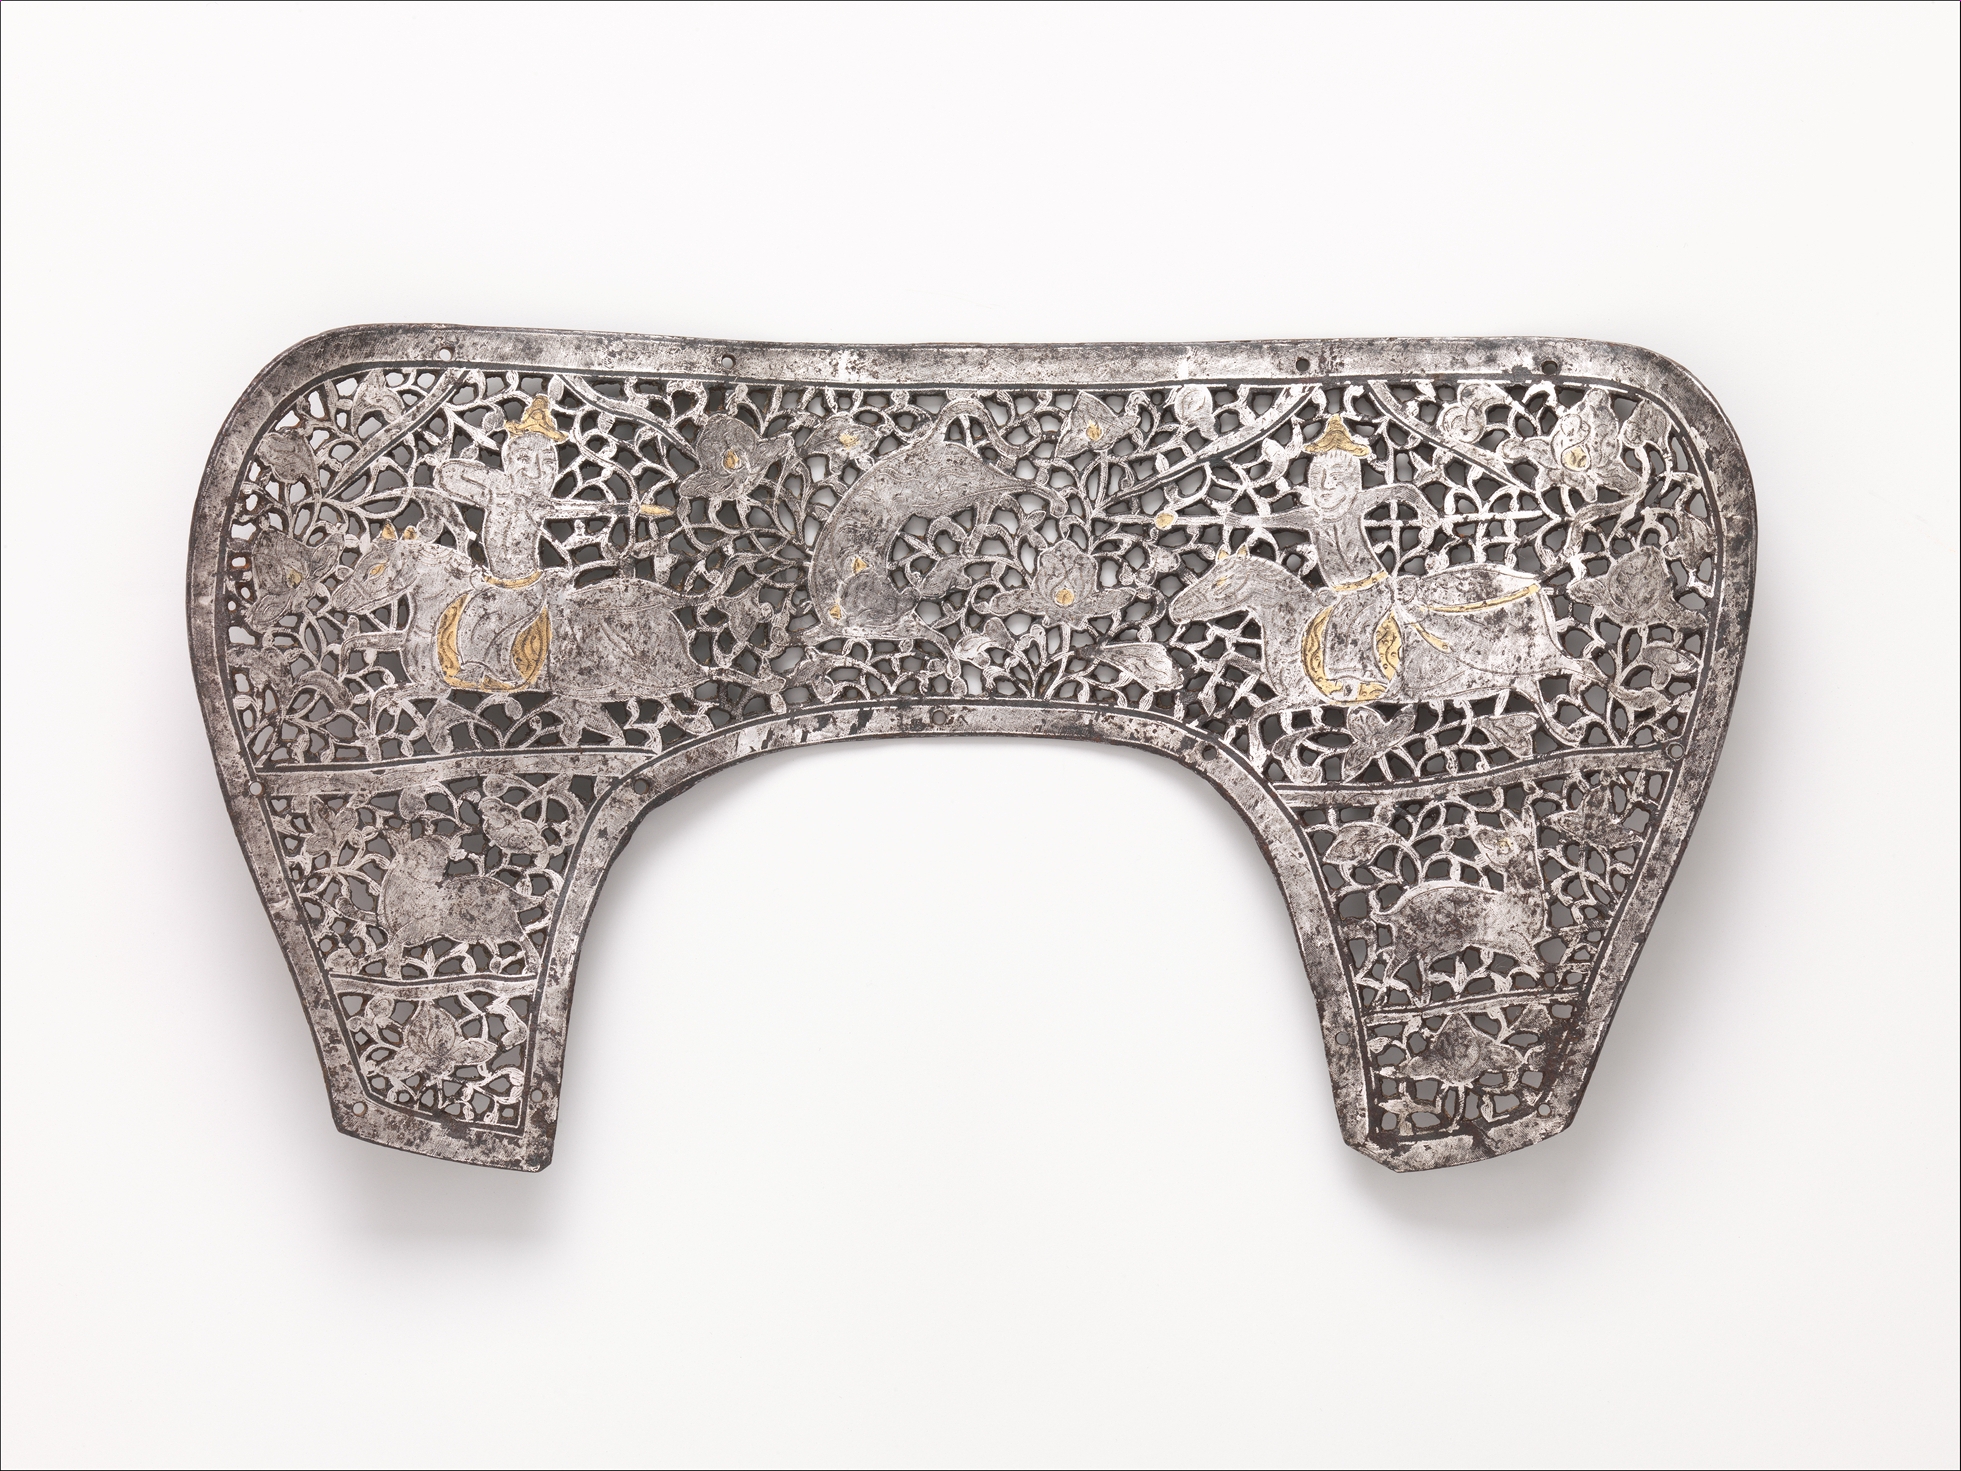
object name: pommel plate from a saddle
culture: mongolian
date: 1201-1500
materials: gold, iron, silver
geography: mongolia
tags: men,horses